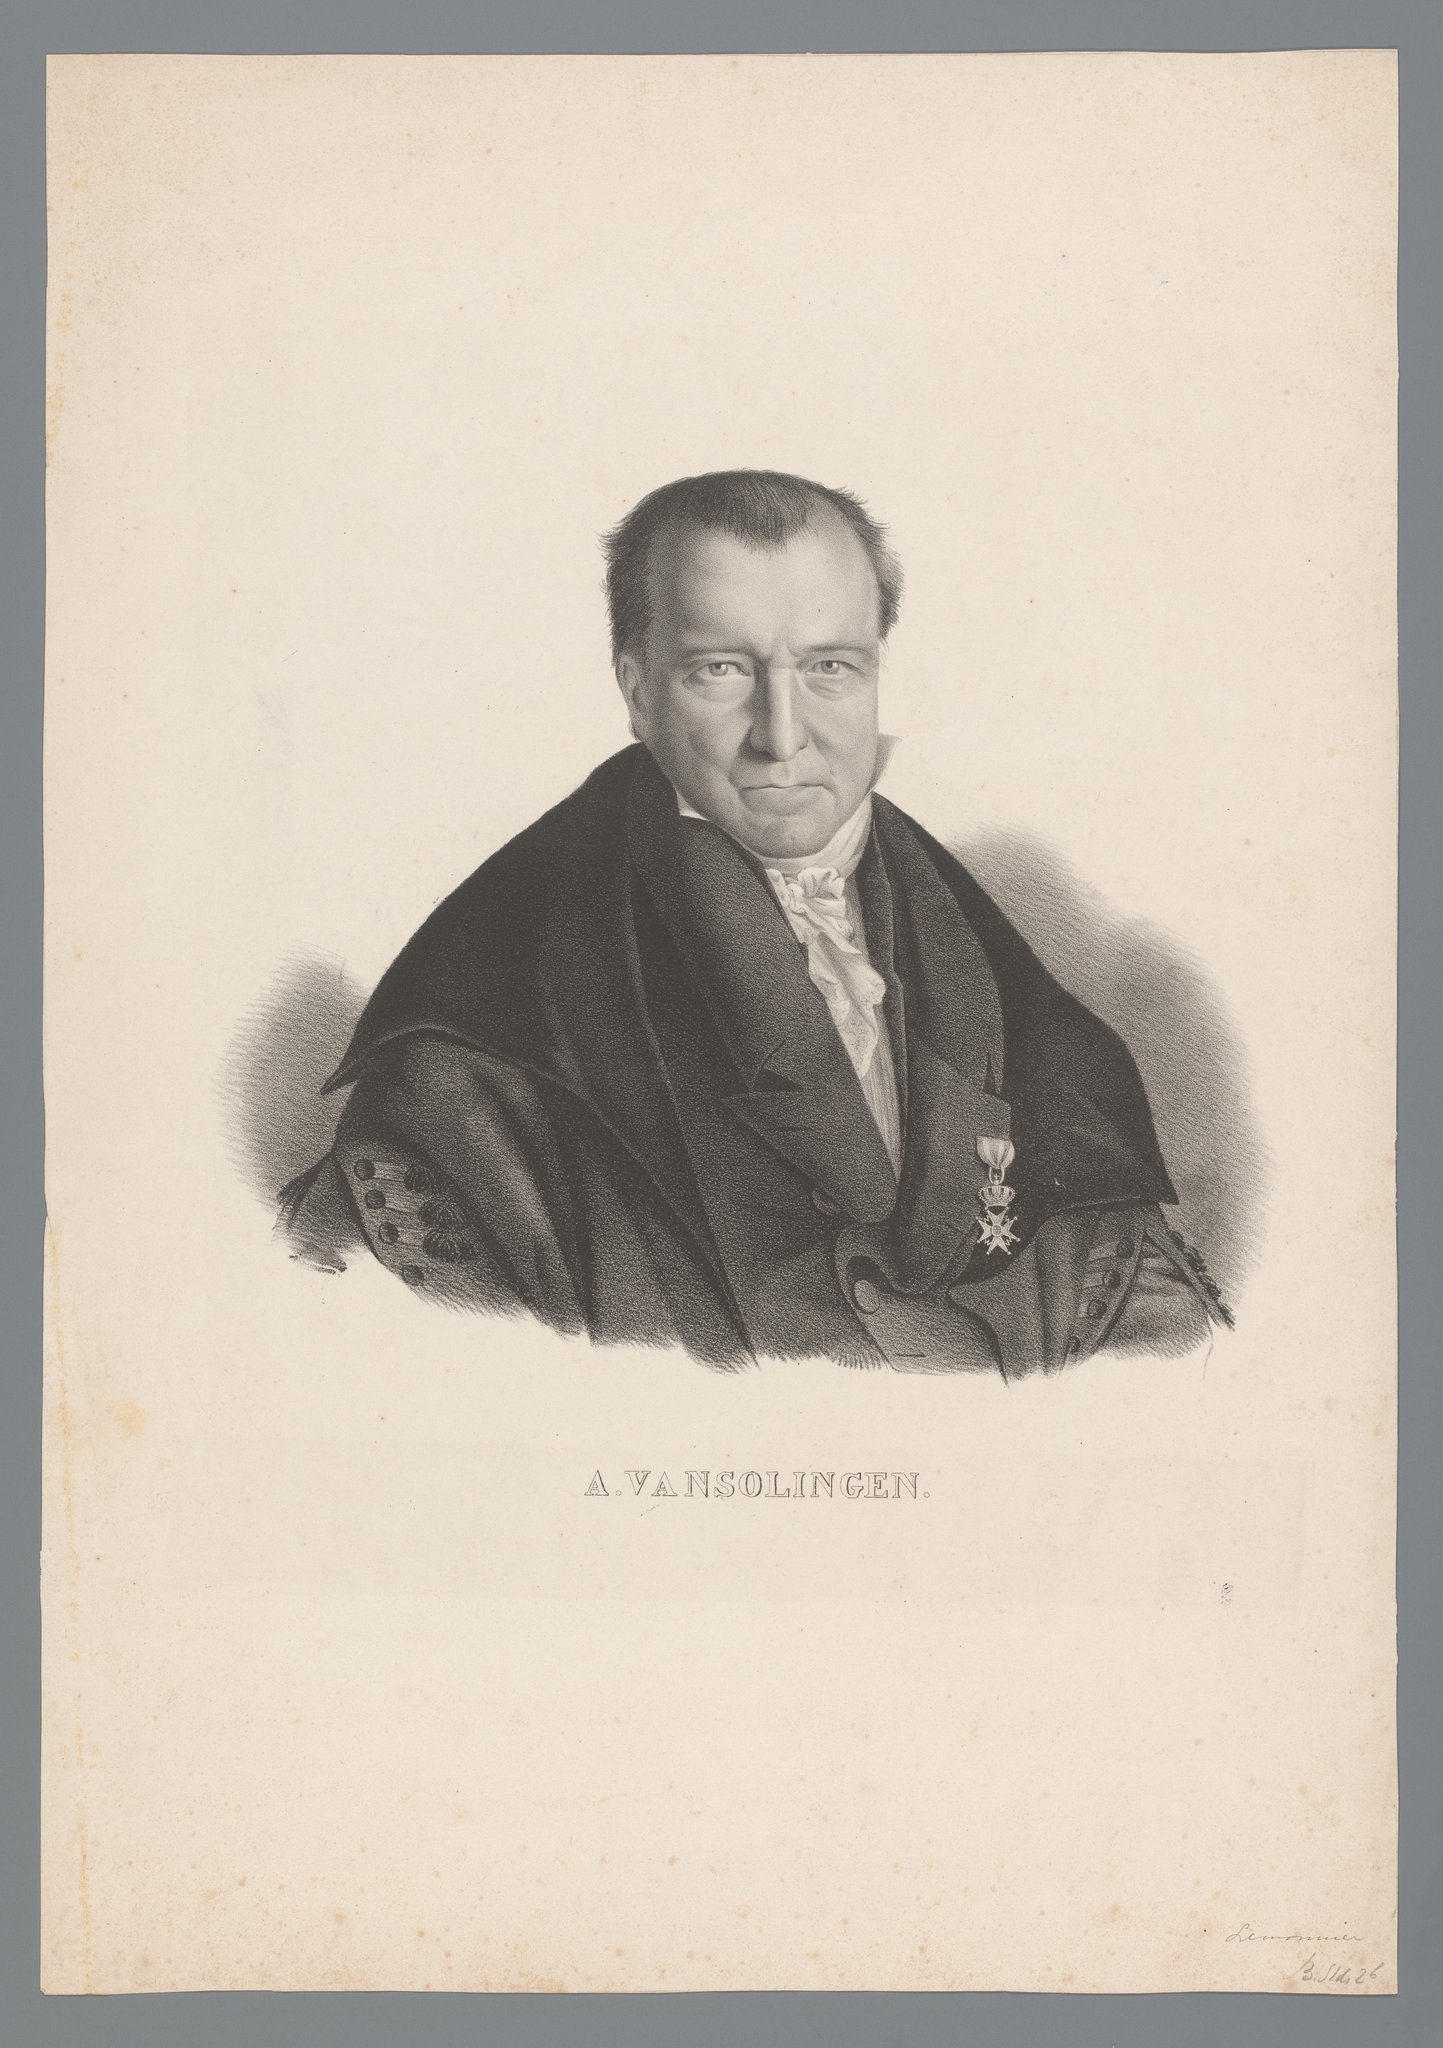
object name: print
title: A. van Solingen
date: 1813-1849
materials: paper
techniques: lithograph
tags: middelburg, adult man, historical persons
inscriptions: collector's mark: Lugt 2228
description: Prent lijkt erg veel op RP-P-1905-4750. Hierop staan de vervaardigers vermeld en deze prent is opgenomen in Muller, 1853.